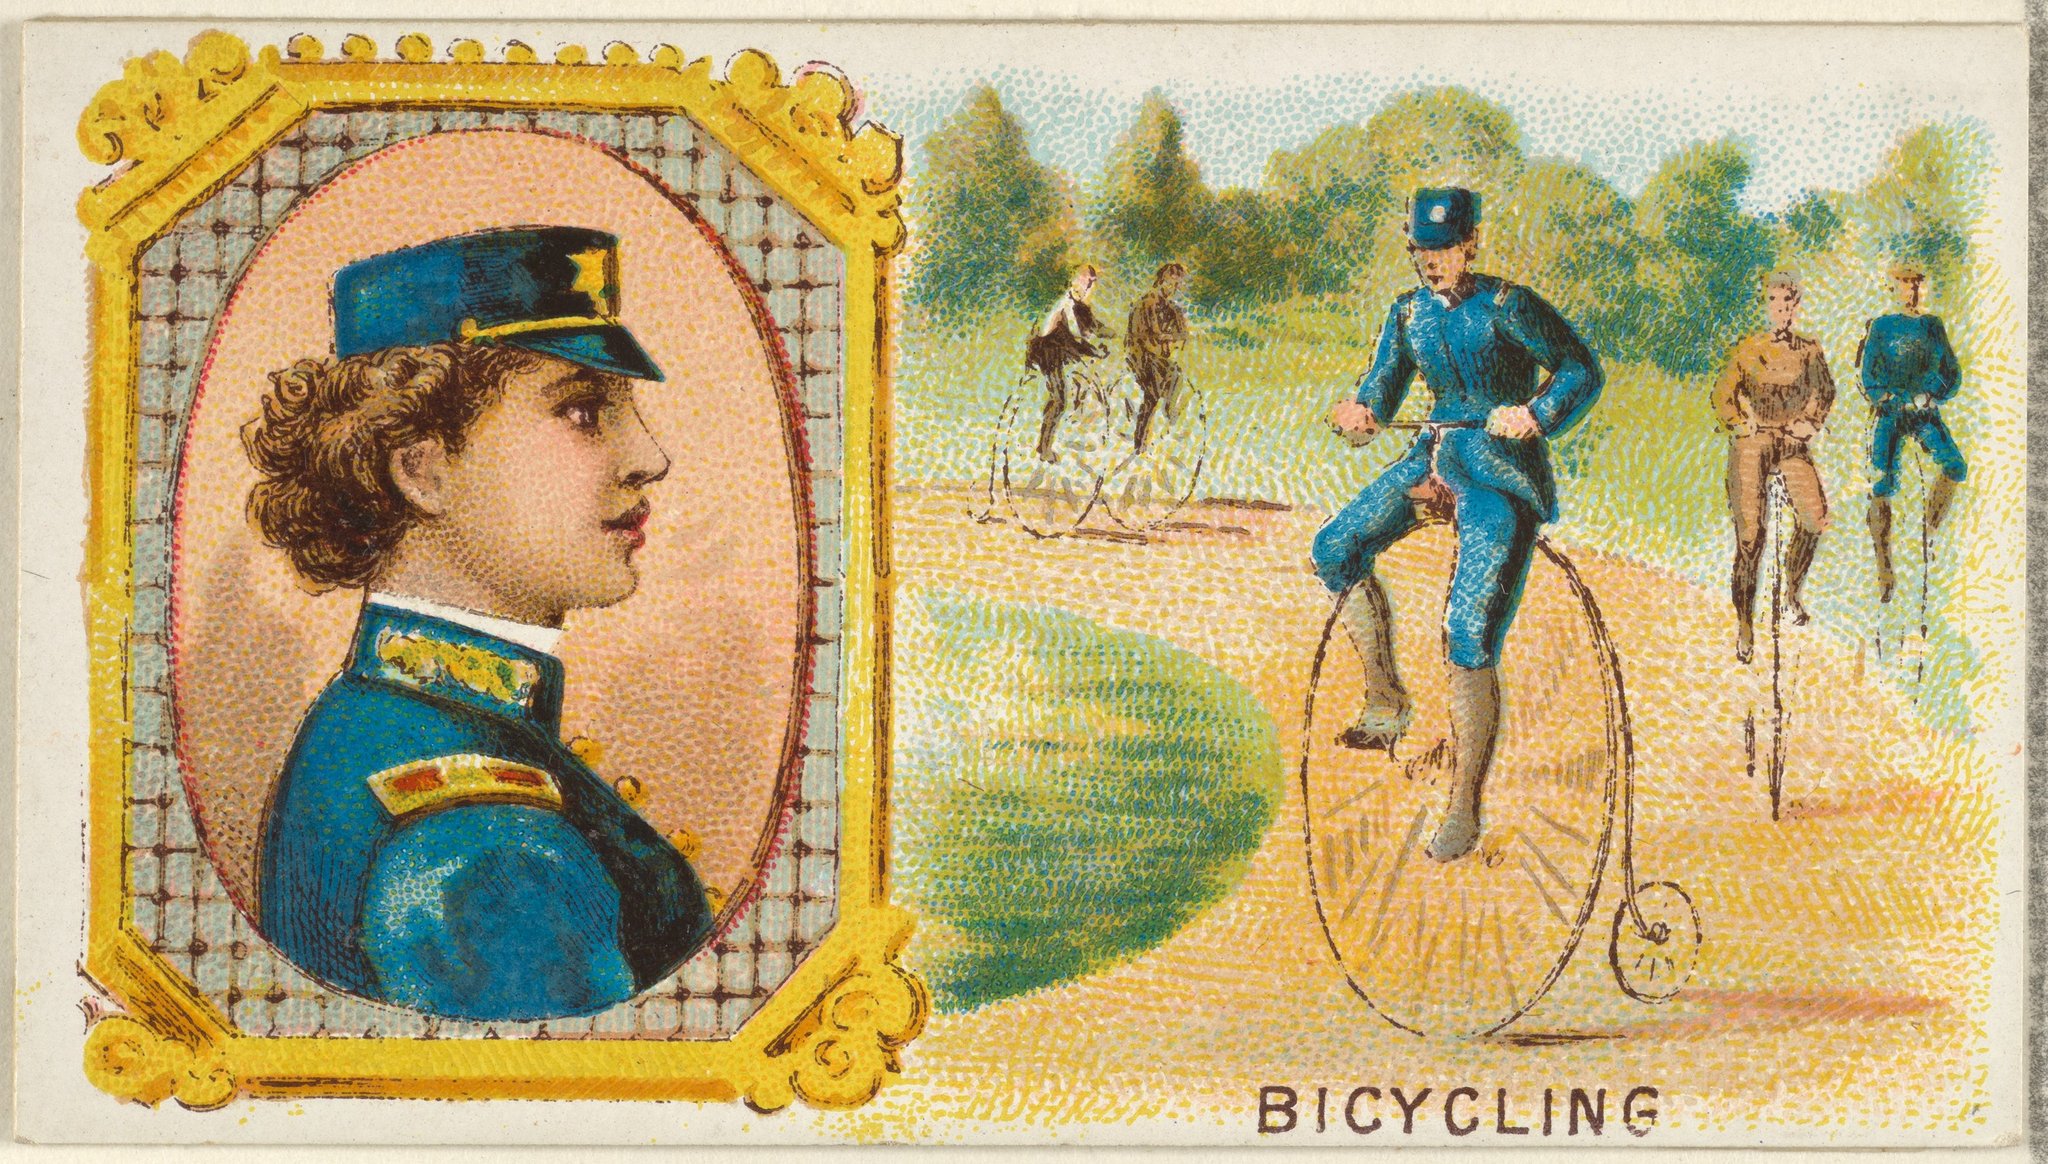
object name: print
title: Bicycling, from the Games and Sports series (N165) for Old Judge Cigarettes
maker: goodwin & company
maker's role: publisher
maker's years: 1850-1950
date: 1889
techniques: color lithograph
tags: men,women,sports,athletes